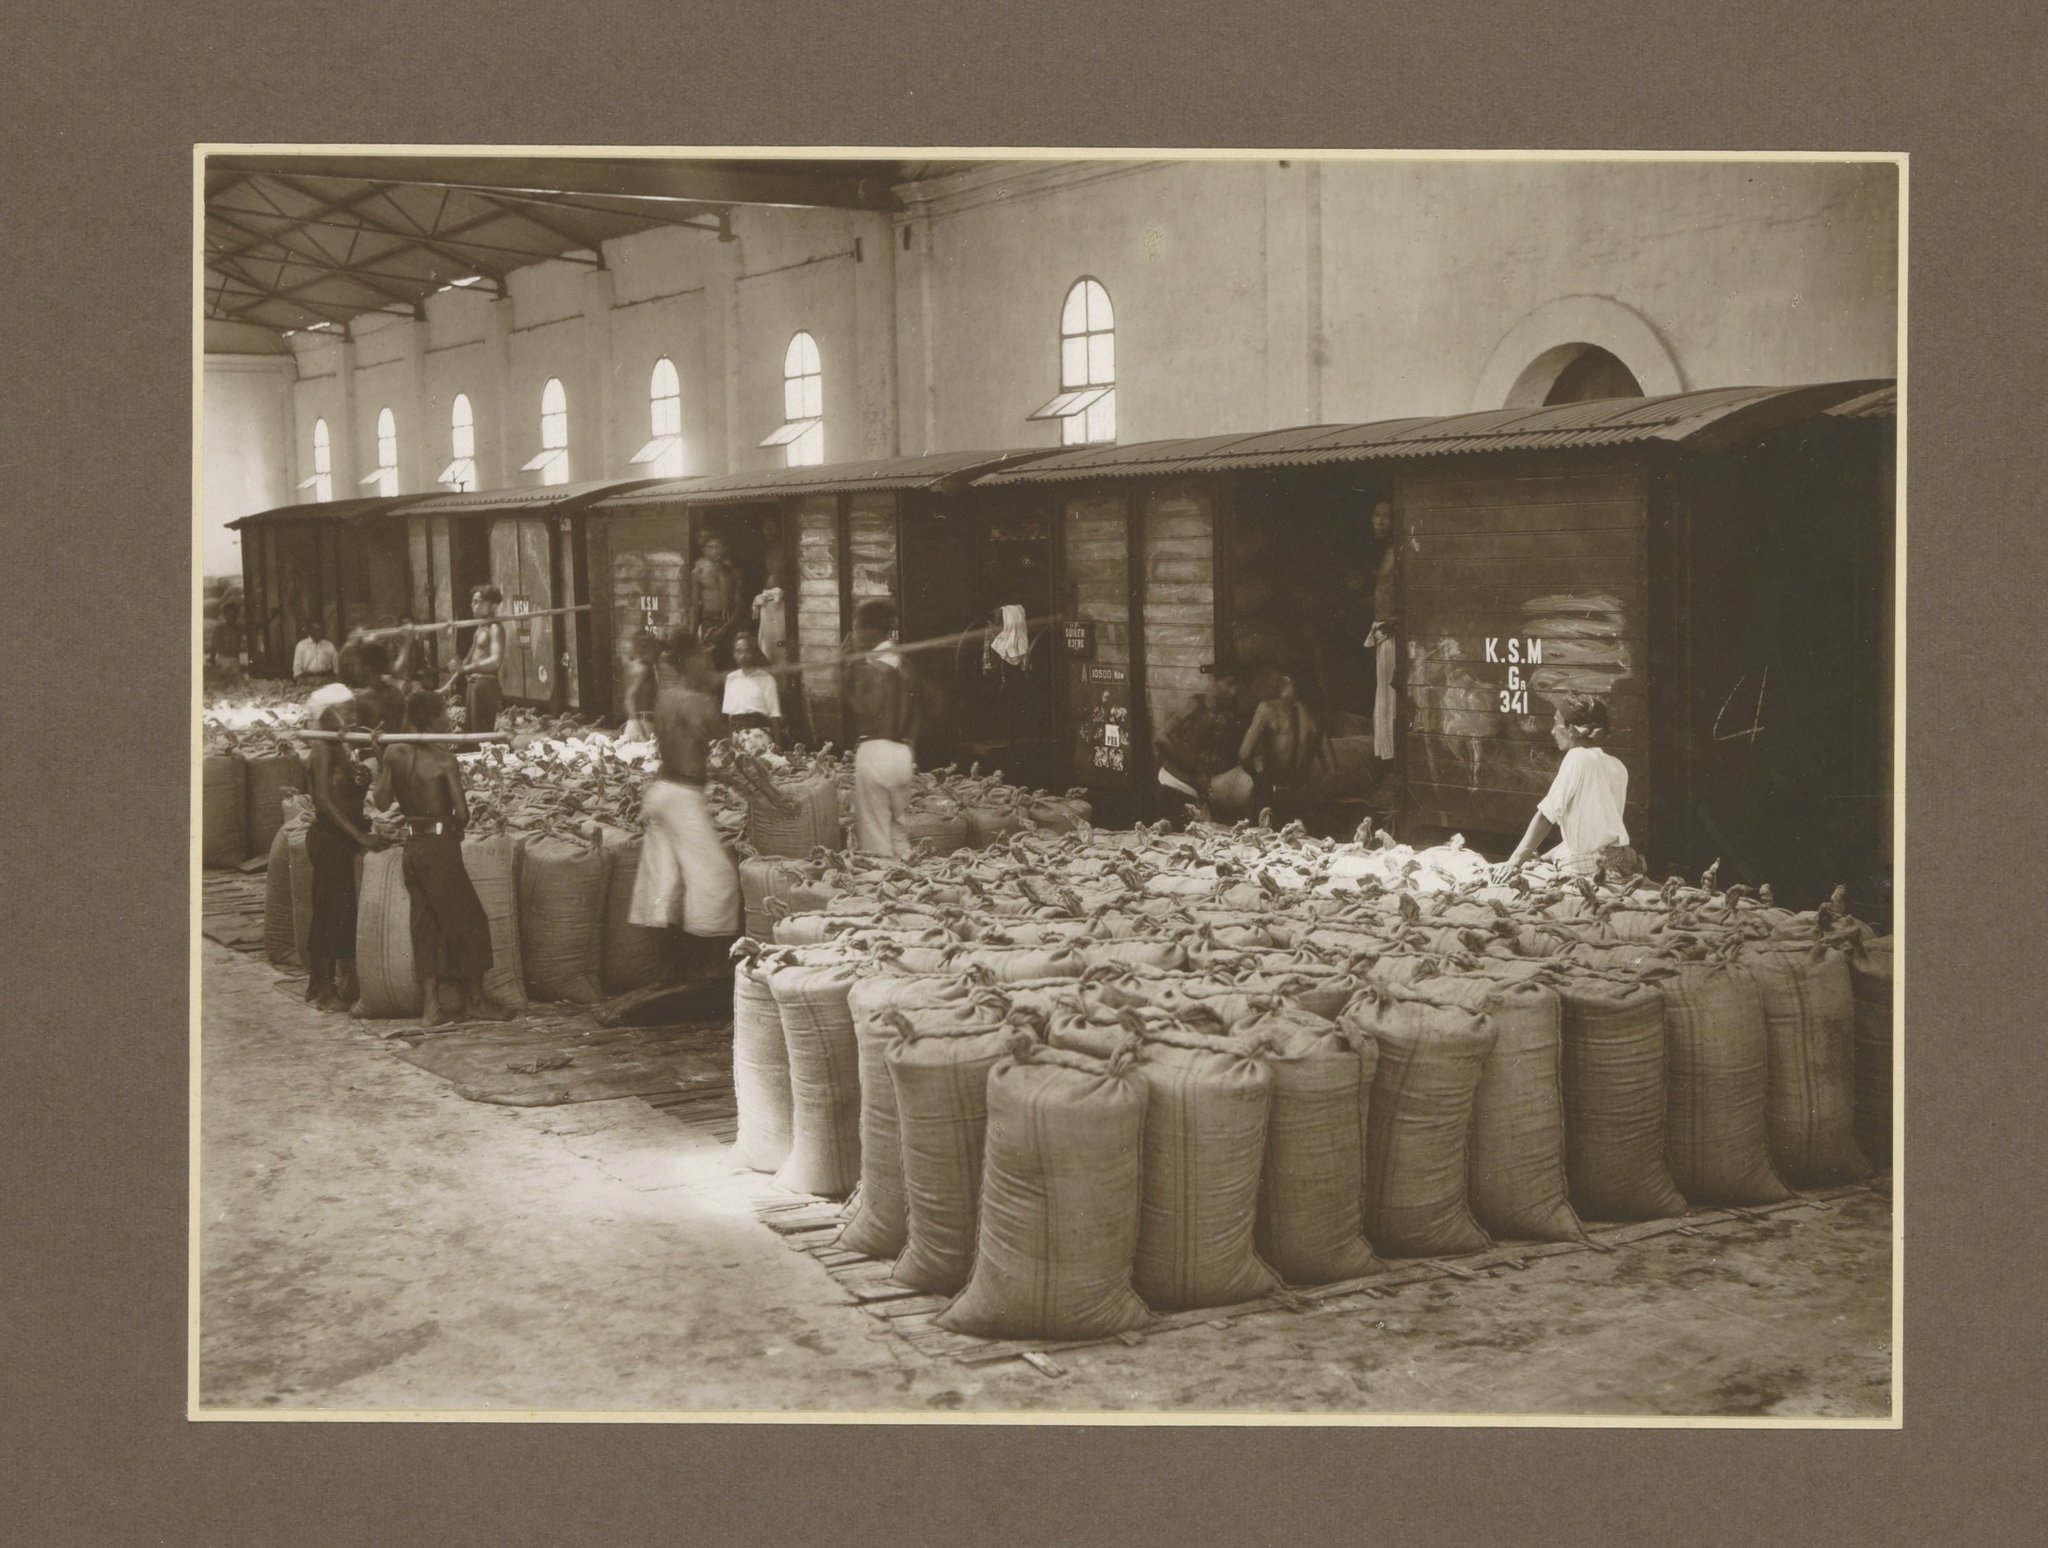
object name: album leaf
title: Werknemers in een verpakkingsloods van suikerfabriek Boedoeran in Sidoarjo op Java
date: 1925-1930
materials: cardboard, paper, photographic support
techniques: gelatin silver print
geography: sidoarjo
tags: plantation, factory-interior, machine shop, storing in sacks ~ harvest, plants and herbs: sugarcane, sugar, dutch east indies, the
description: Onderdeel van Fotoalbum met opnames van vier suikerfabrieken op Java.